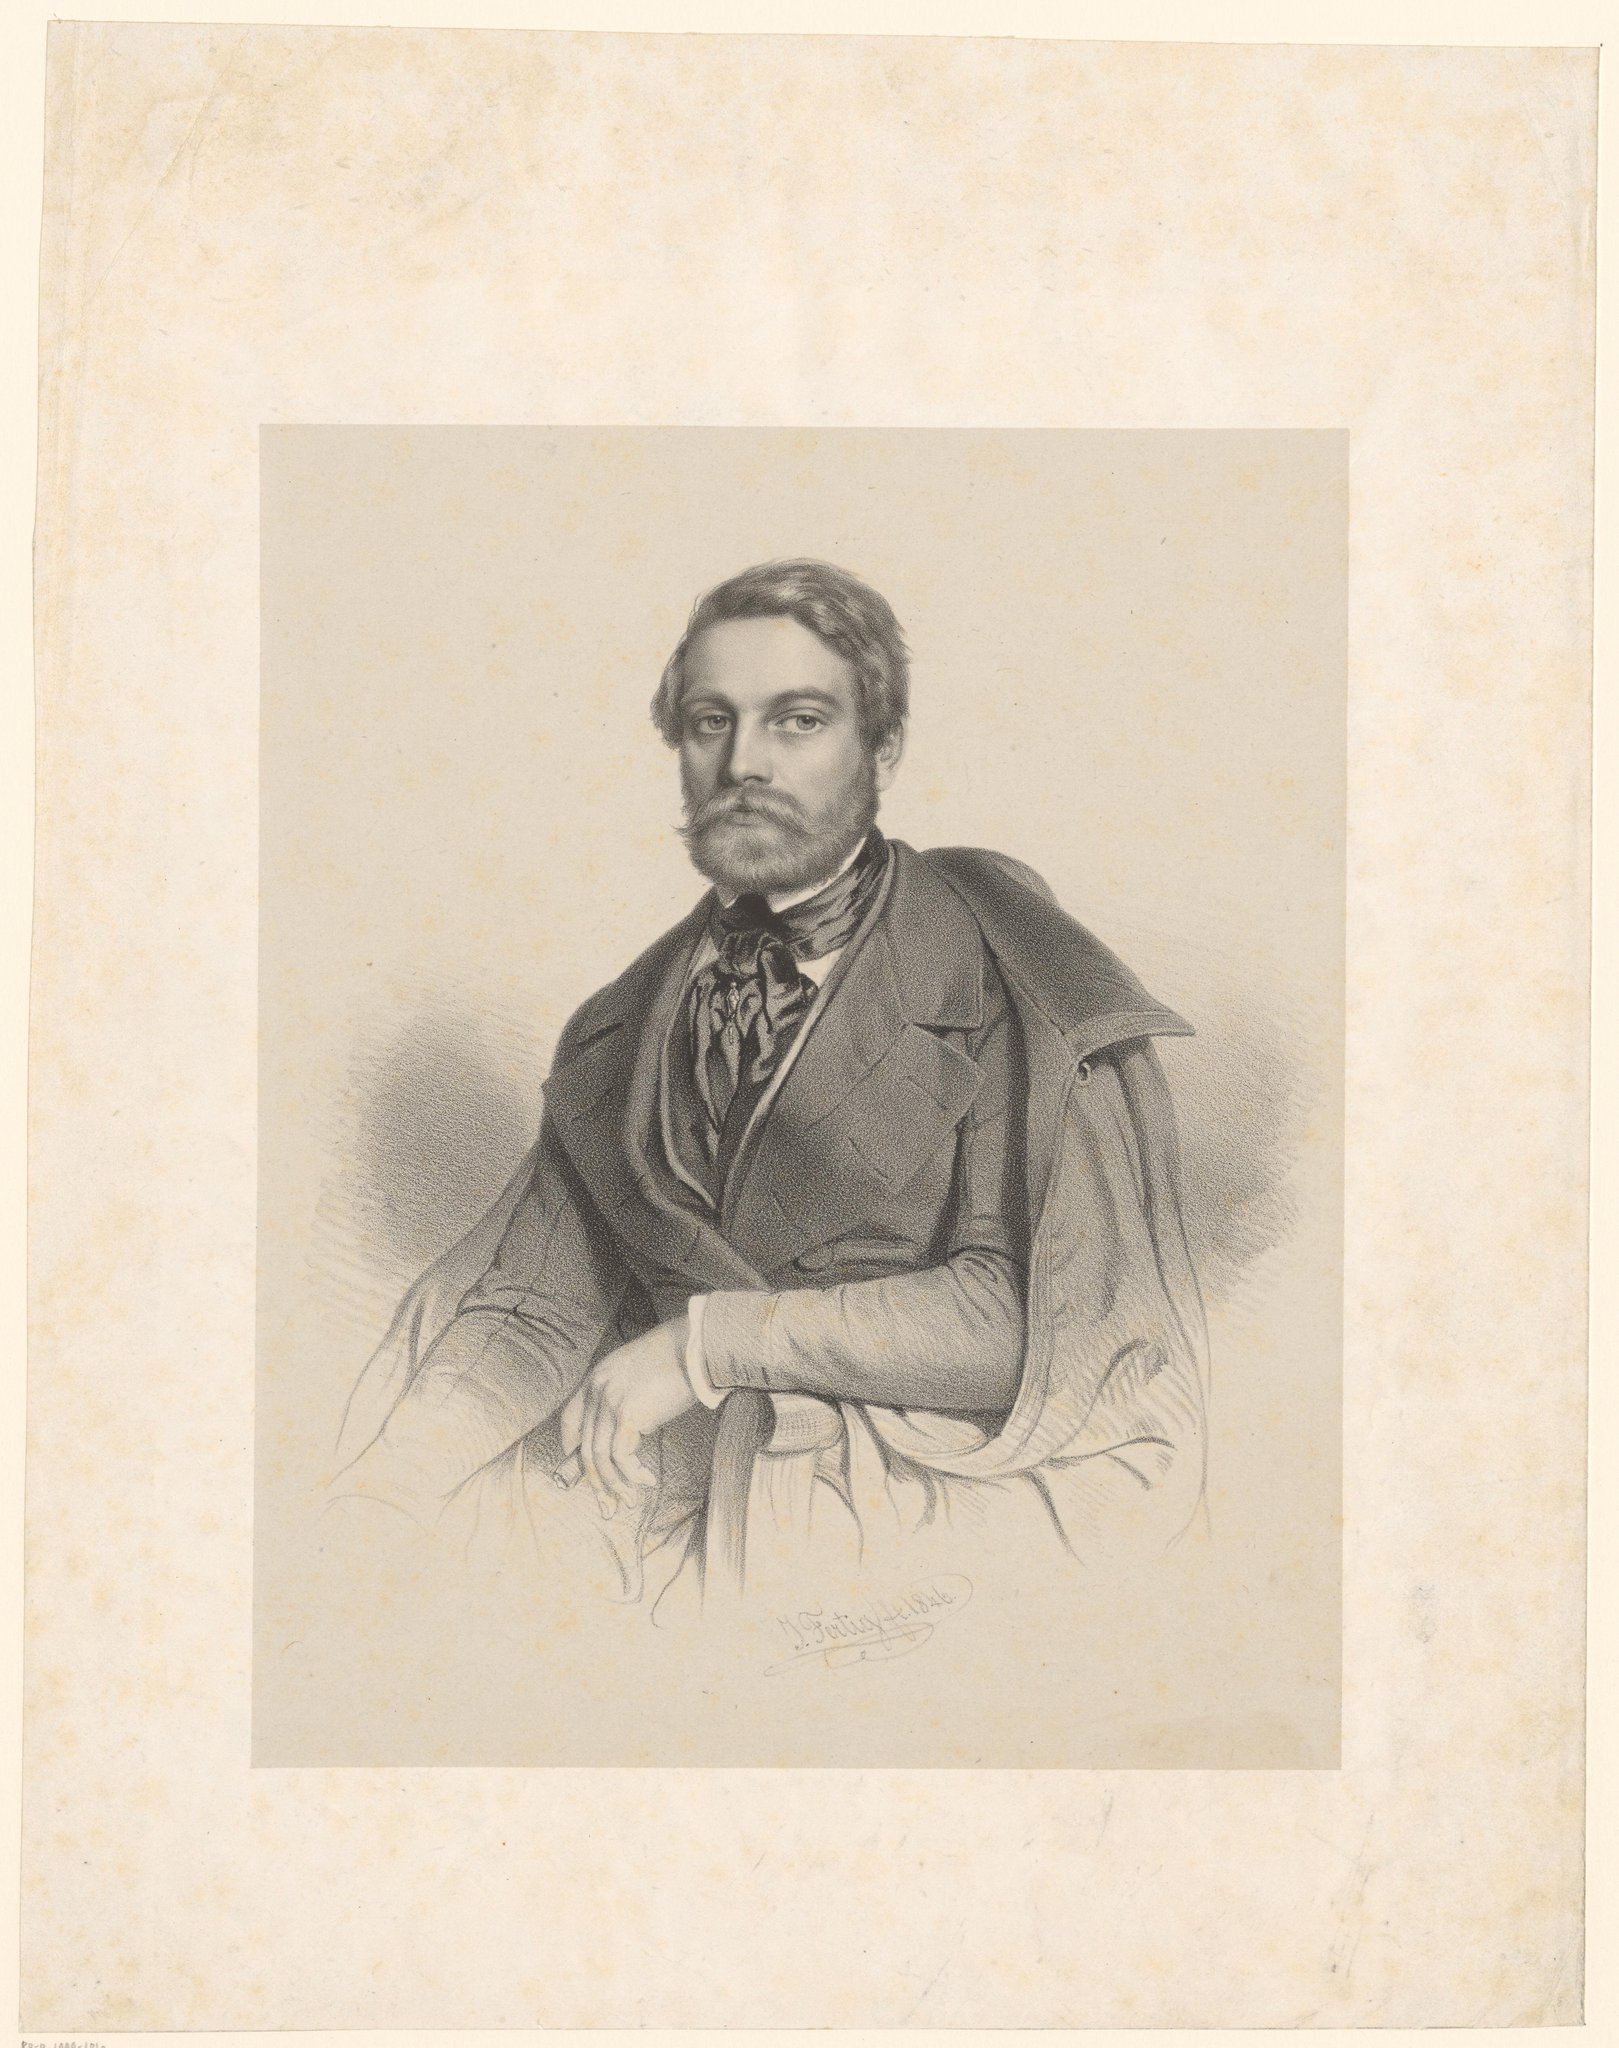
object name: print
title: Portret van een onbekende man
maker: ignaz fertig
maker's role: print maker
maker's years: 1809-1858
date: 1846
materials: paper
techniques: lithograph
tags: historical persons not known by name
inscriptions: collector's mark: Lugt 2228, collector's mark: Lugt 2760